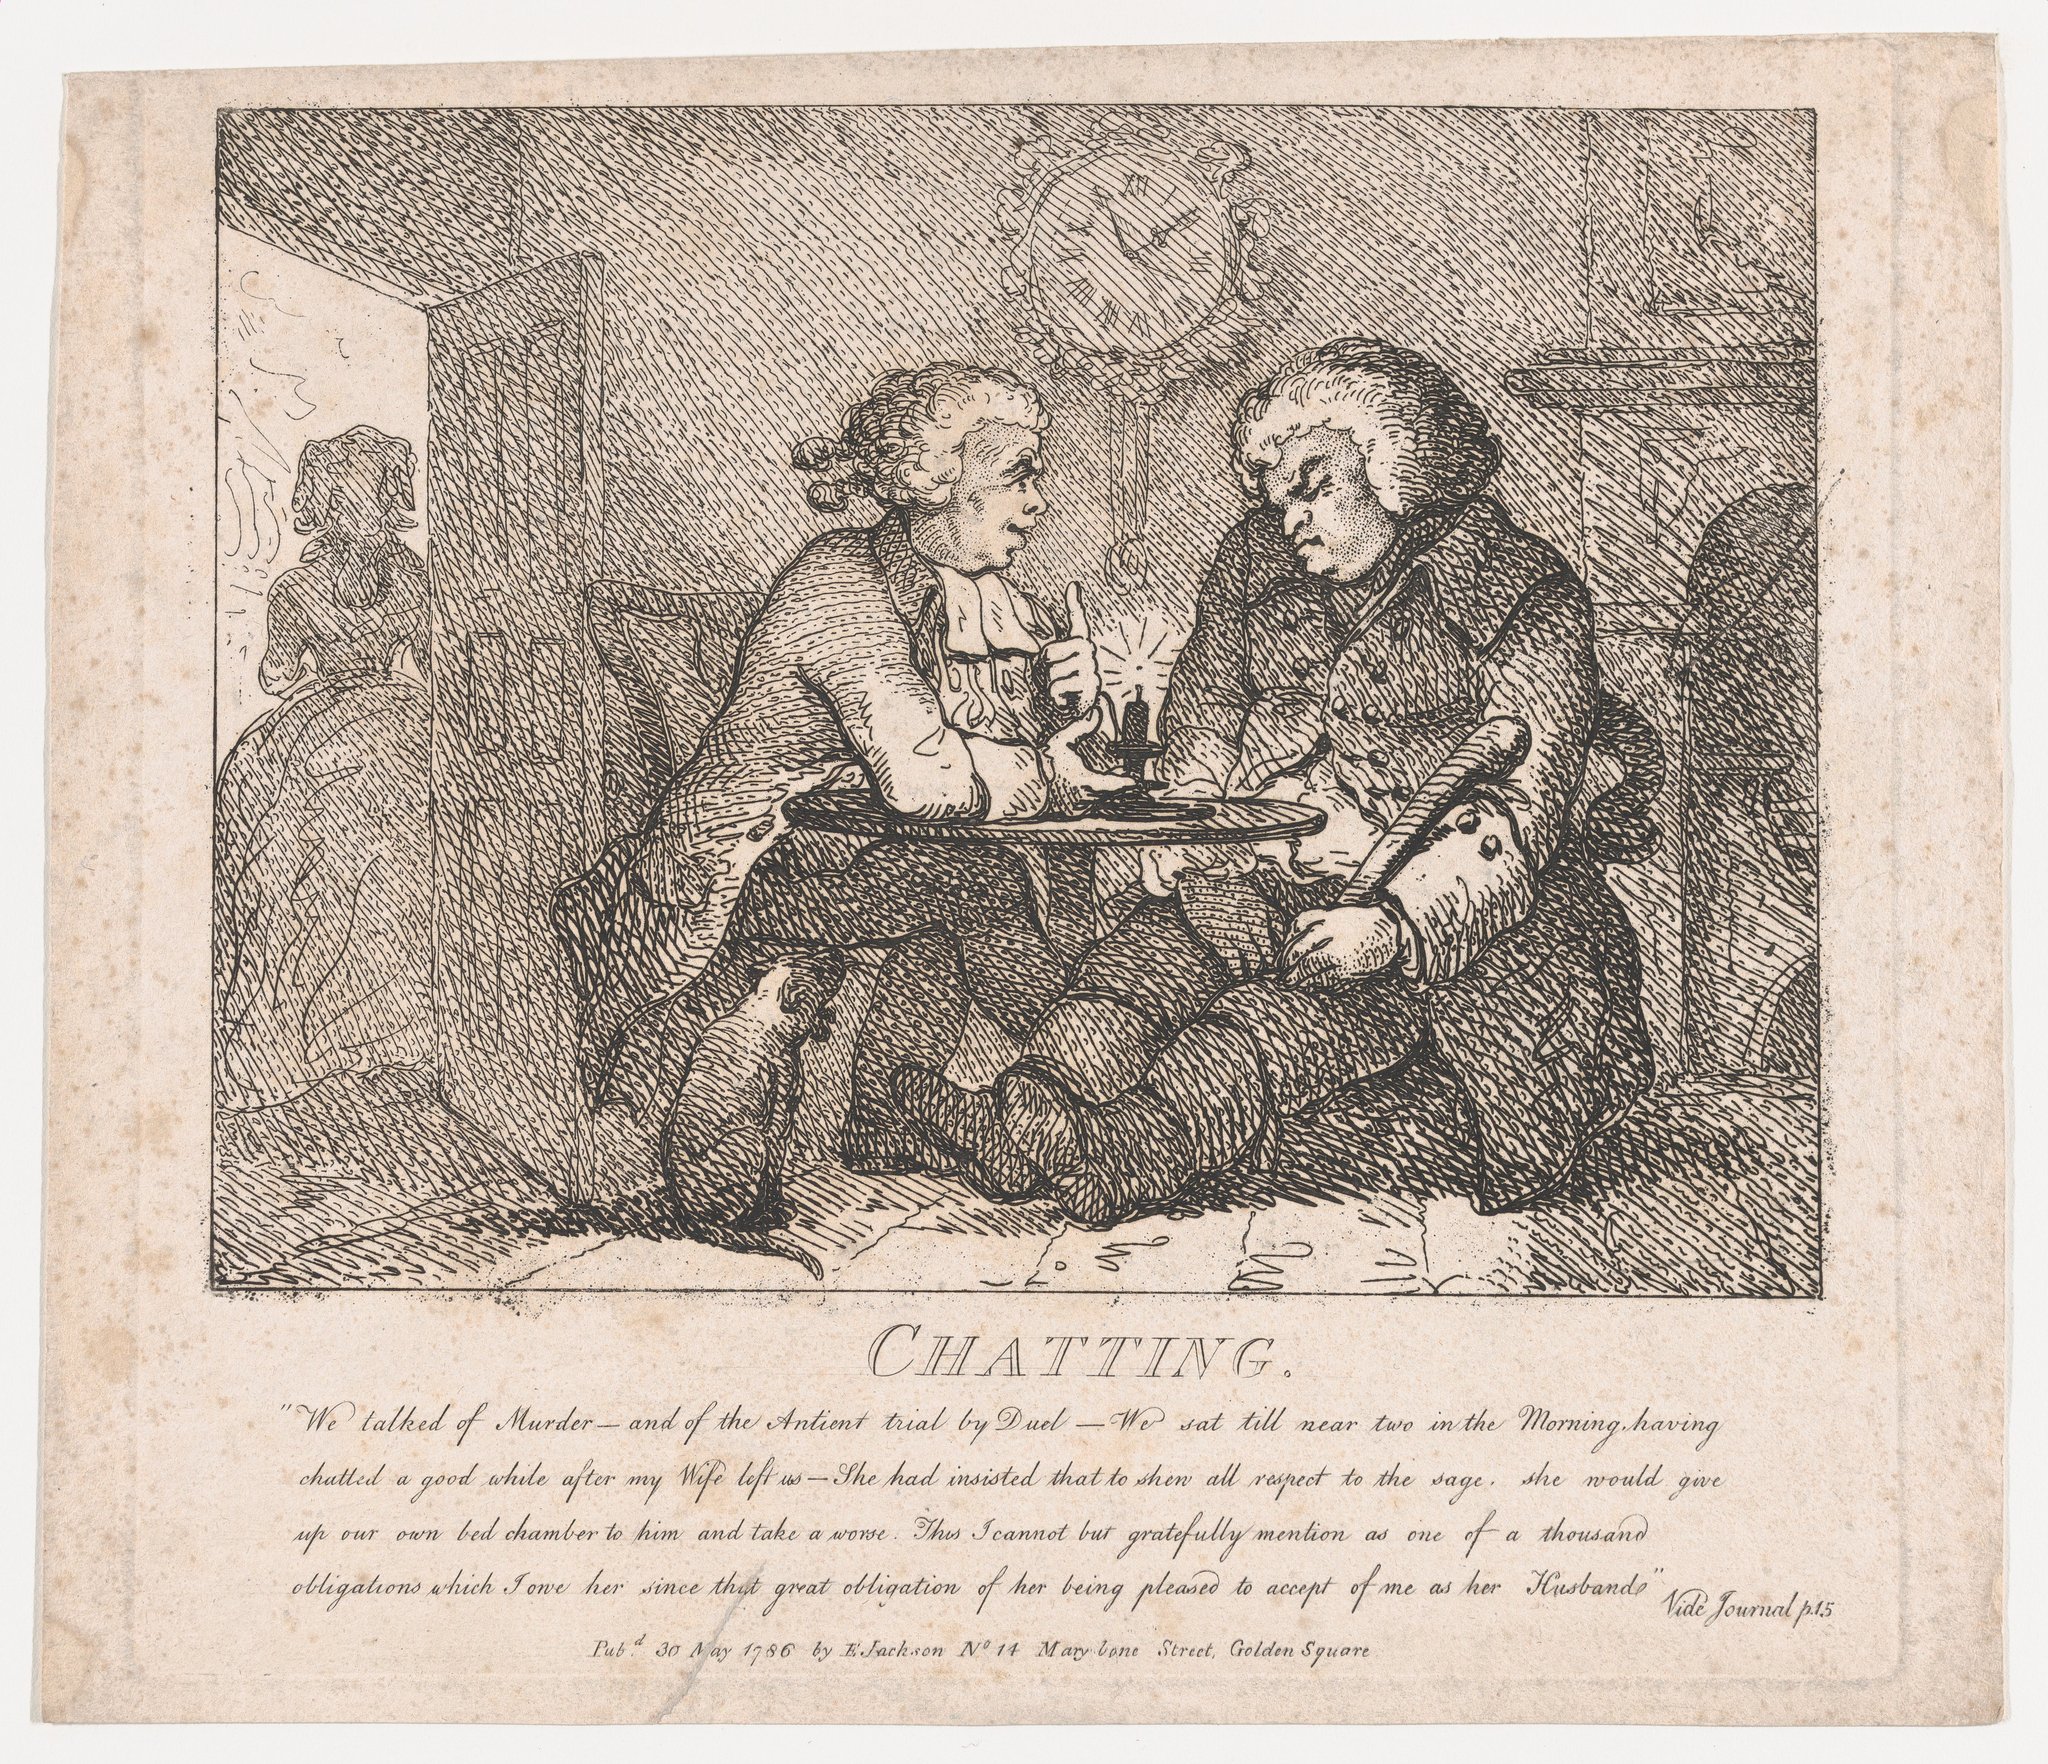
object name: print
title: Chatting (Picturesque Beauties of Boswell, Part the First)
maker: thomas rowlandson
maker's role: artist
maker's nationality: british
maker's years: 1757-1827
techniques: etching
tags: men,women